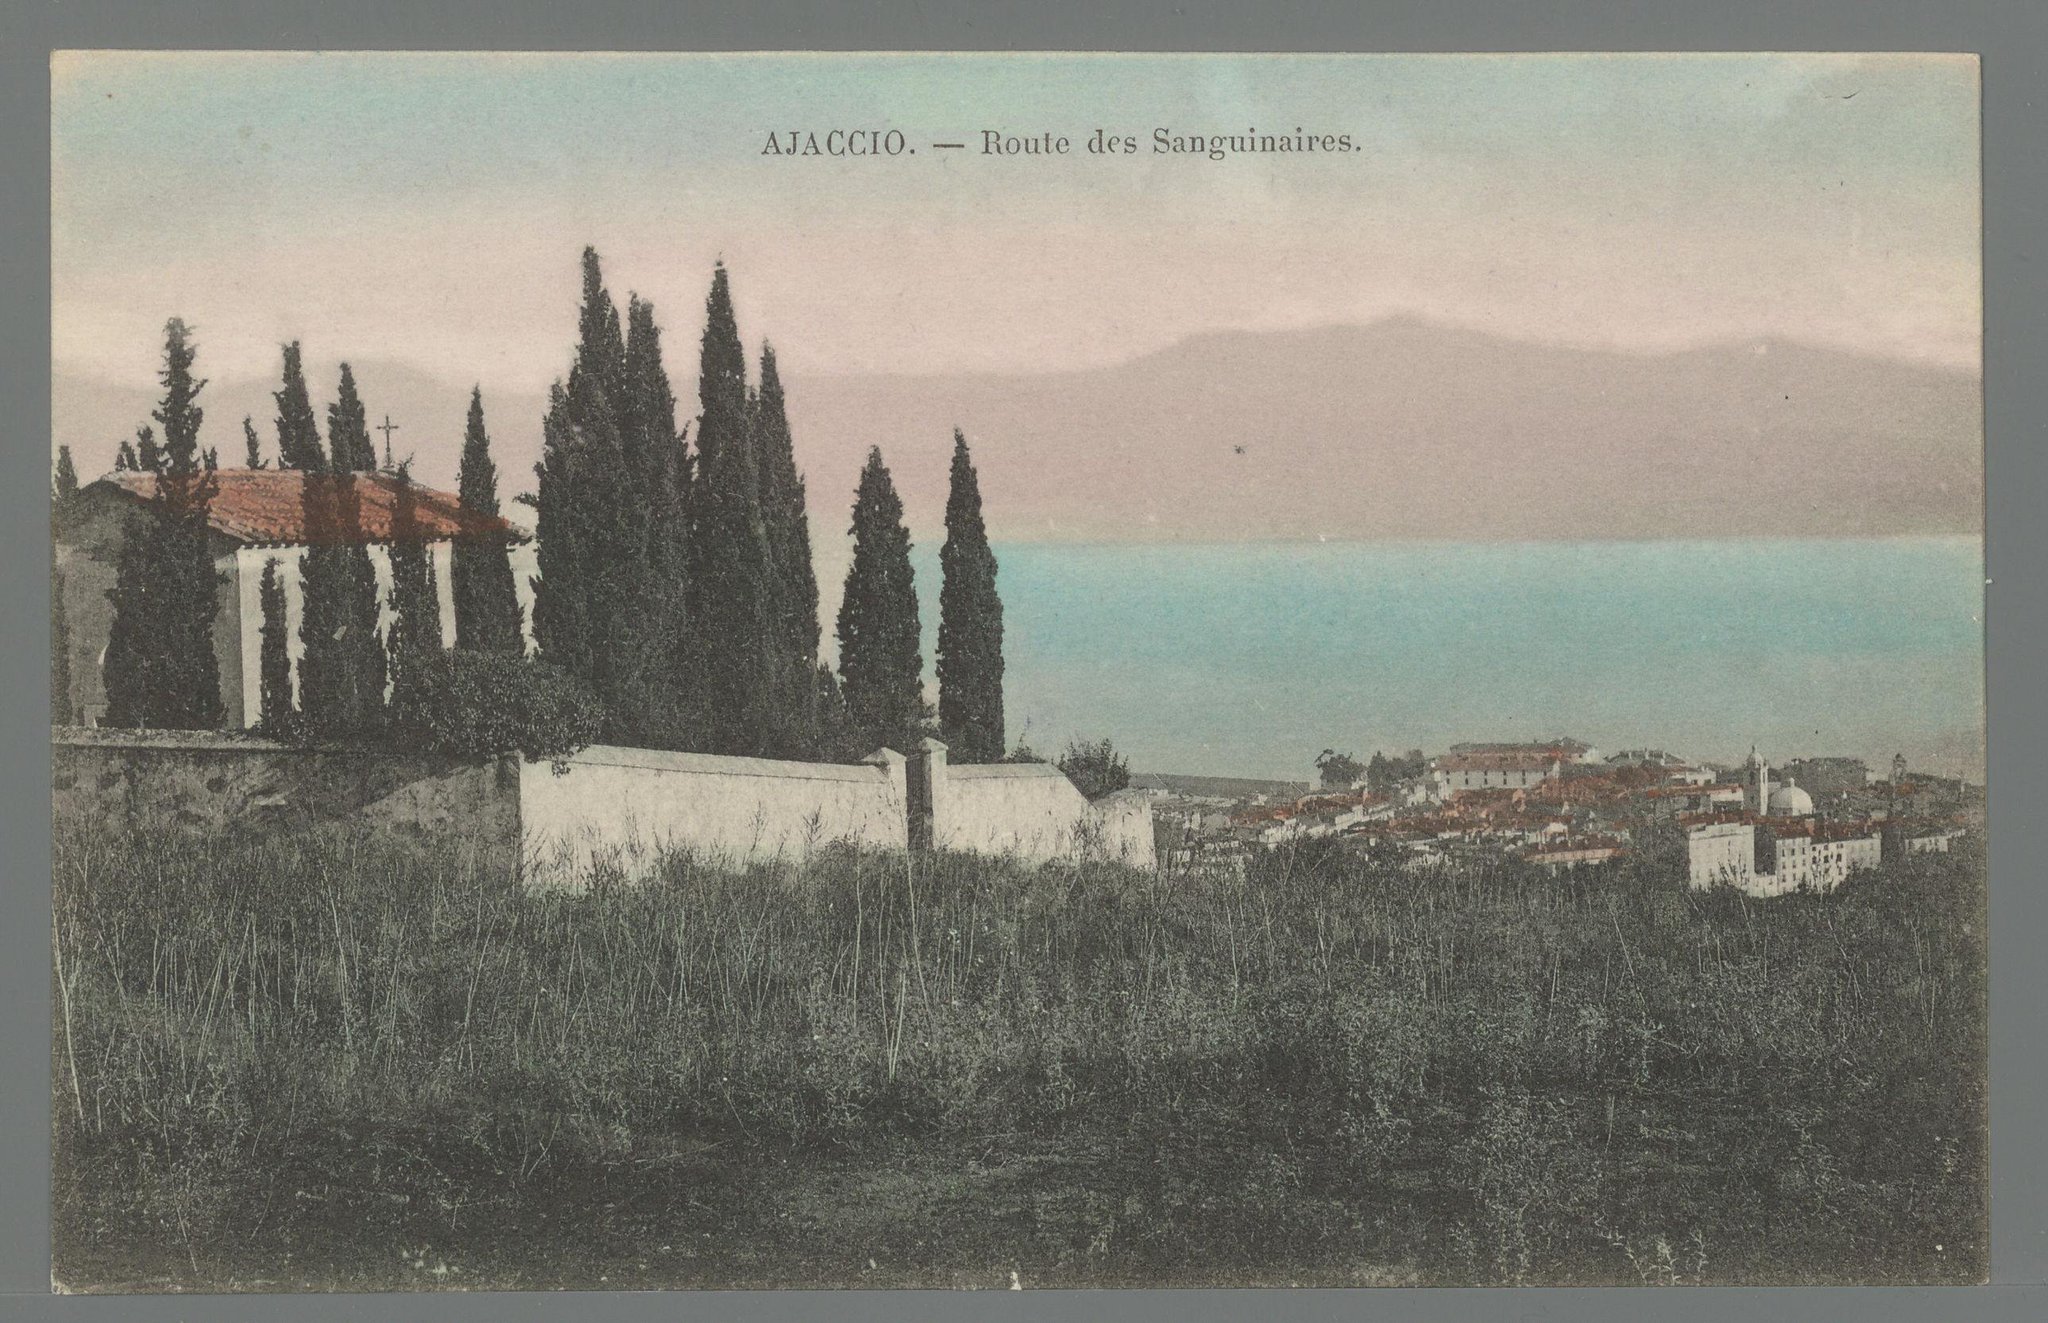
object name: ansichtkaart, prentbriefkaart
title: Ajaccio. Route des Sanguinaires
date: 1904-1906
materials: cardboard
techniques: photograph, hand coloring, writing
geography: ajaccio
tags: sea (seascape), prospect of city, town panorama, silhouette of city